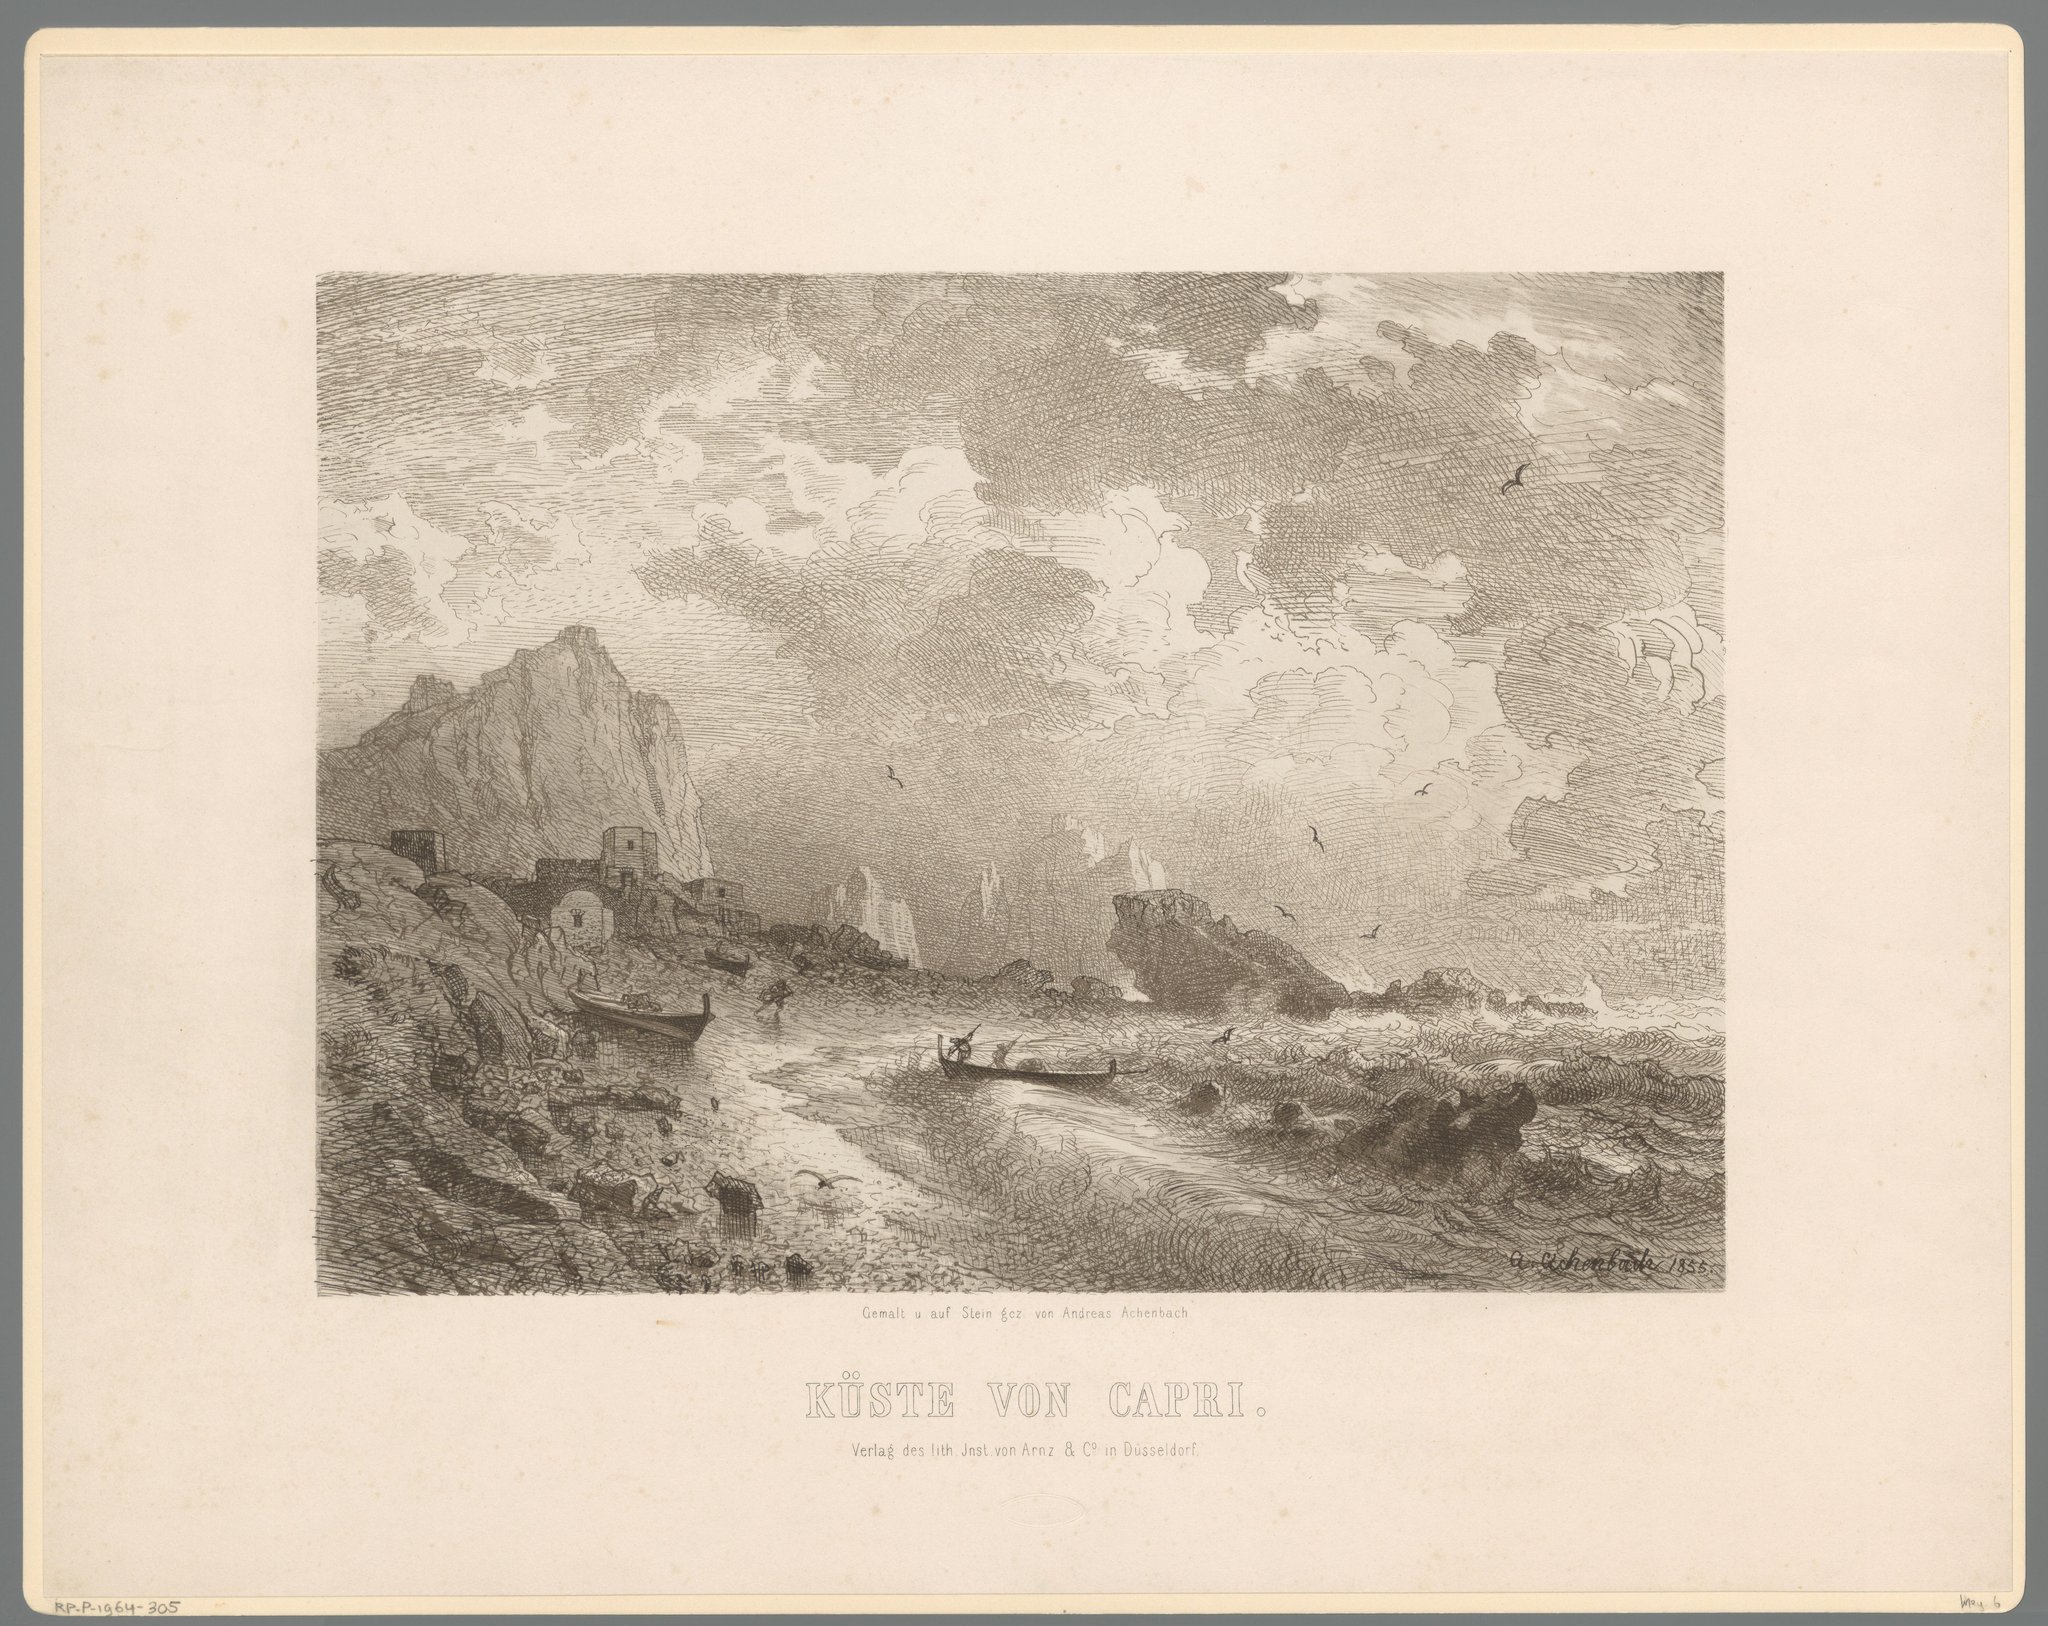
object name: print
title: Küste von Capri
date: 1855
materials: paper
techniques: pen lithography, tone lithography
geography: dusseldorf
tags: rocky coast, capri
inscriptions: check stamp: ‘Lithographisches Institut Arnz & Co in Dusseldorf’, collector's mark: Lugt 2228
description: Volgens Nagler is deze prent verschenen in de niet nader bekende publicatie: Kaufmann, A. Kunst und Literatur. Düsseldorf, 1855.